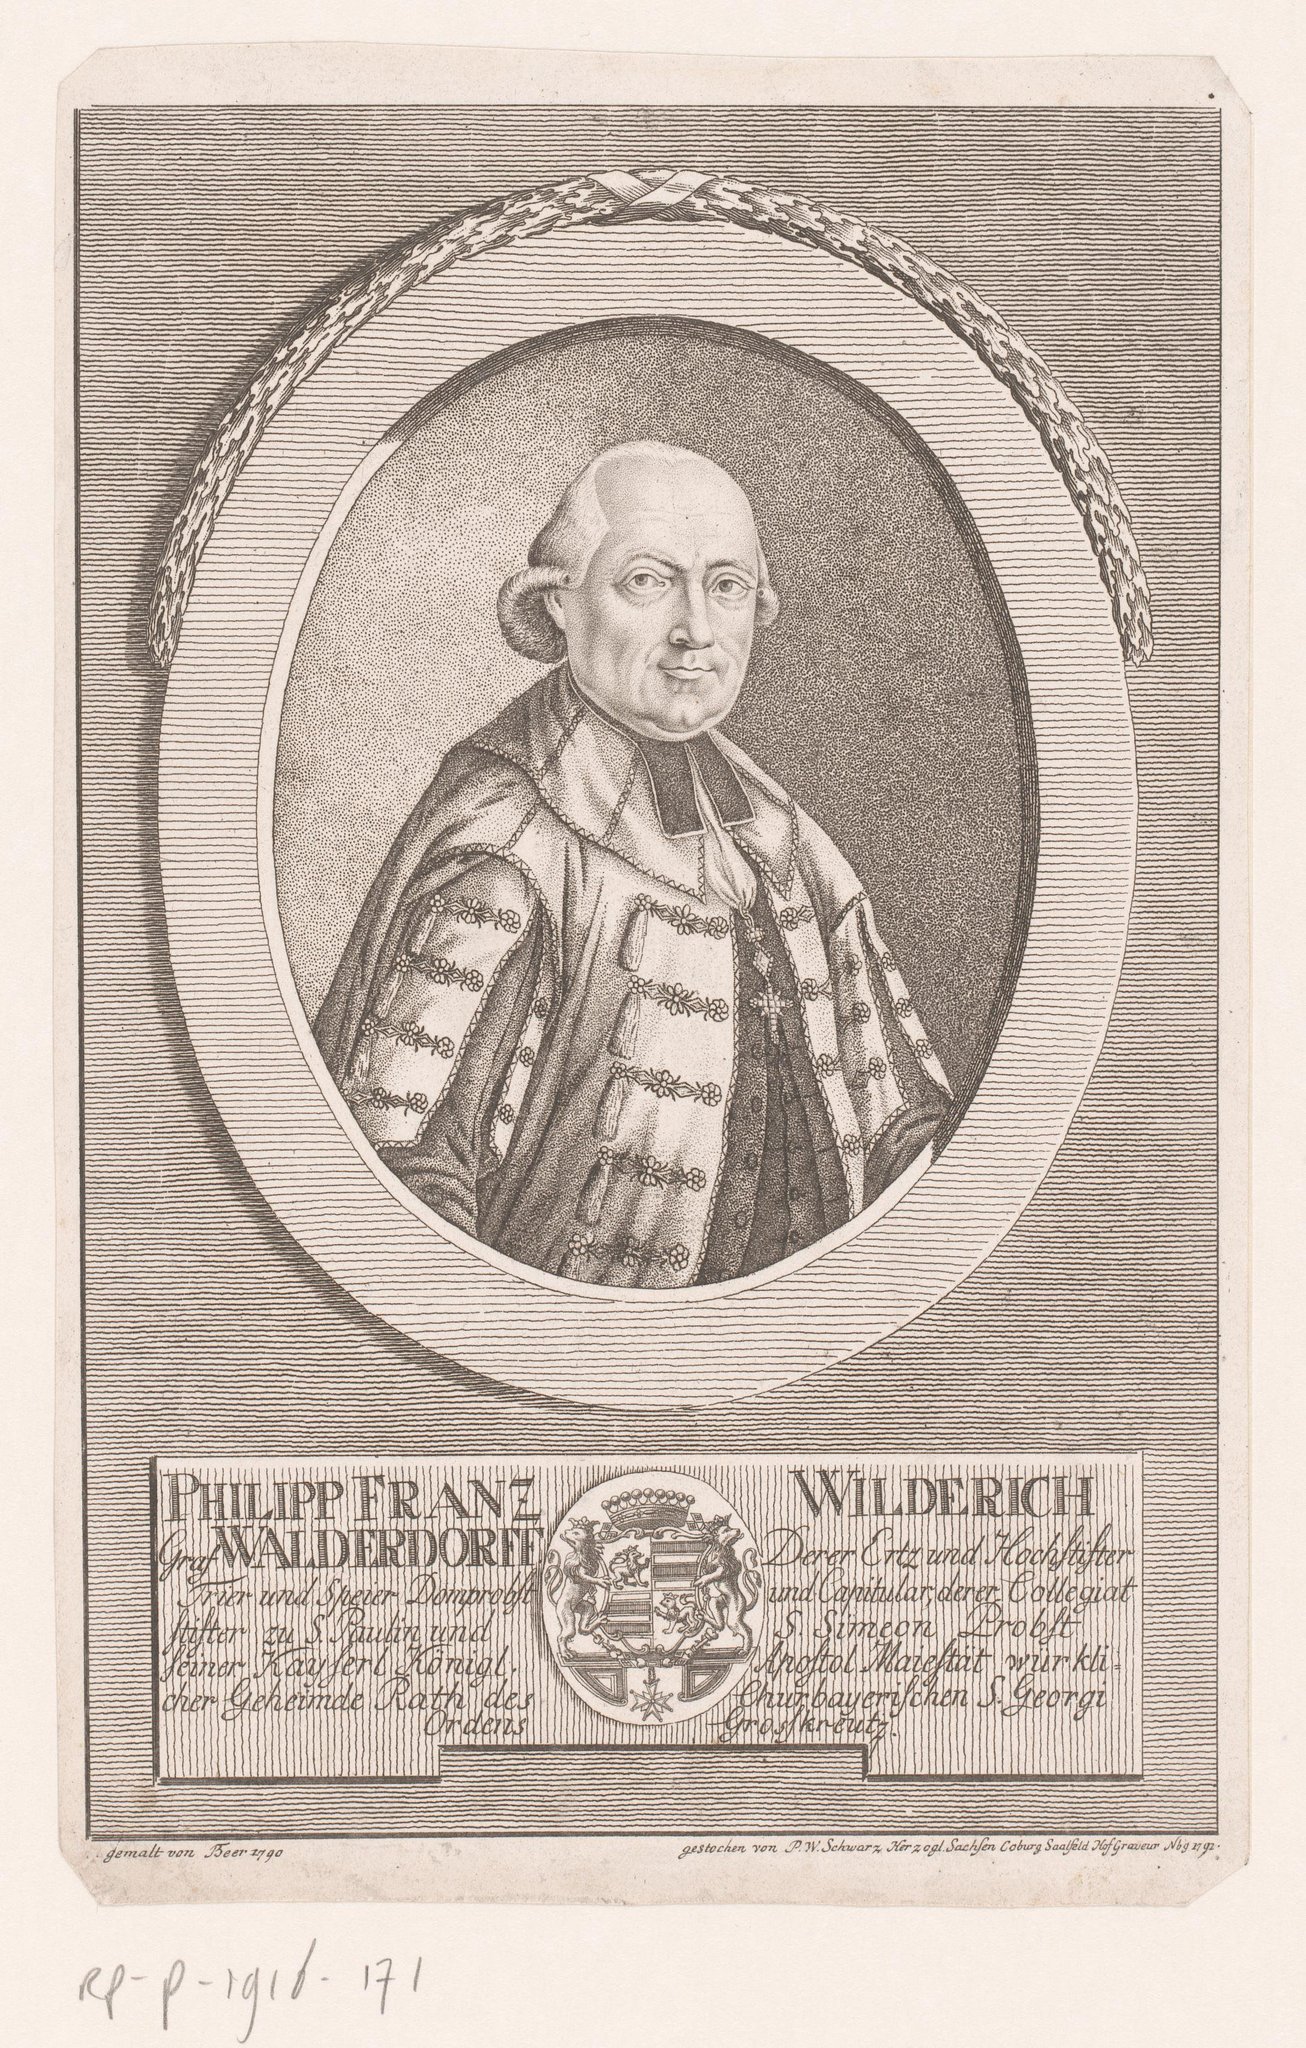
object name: print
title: Portret van Philipp Franz Wilderich Nepomuk von Walderdorf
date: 1792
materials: paper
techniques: etching, engraving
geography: nuremberg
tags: historical persons, armorial bearing, heraldry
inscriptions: collector's mark: Lugt 2228